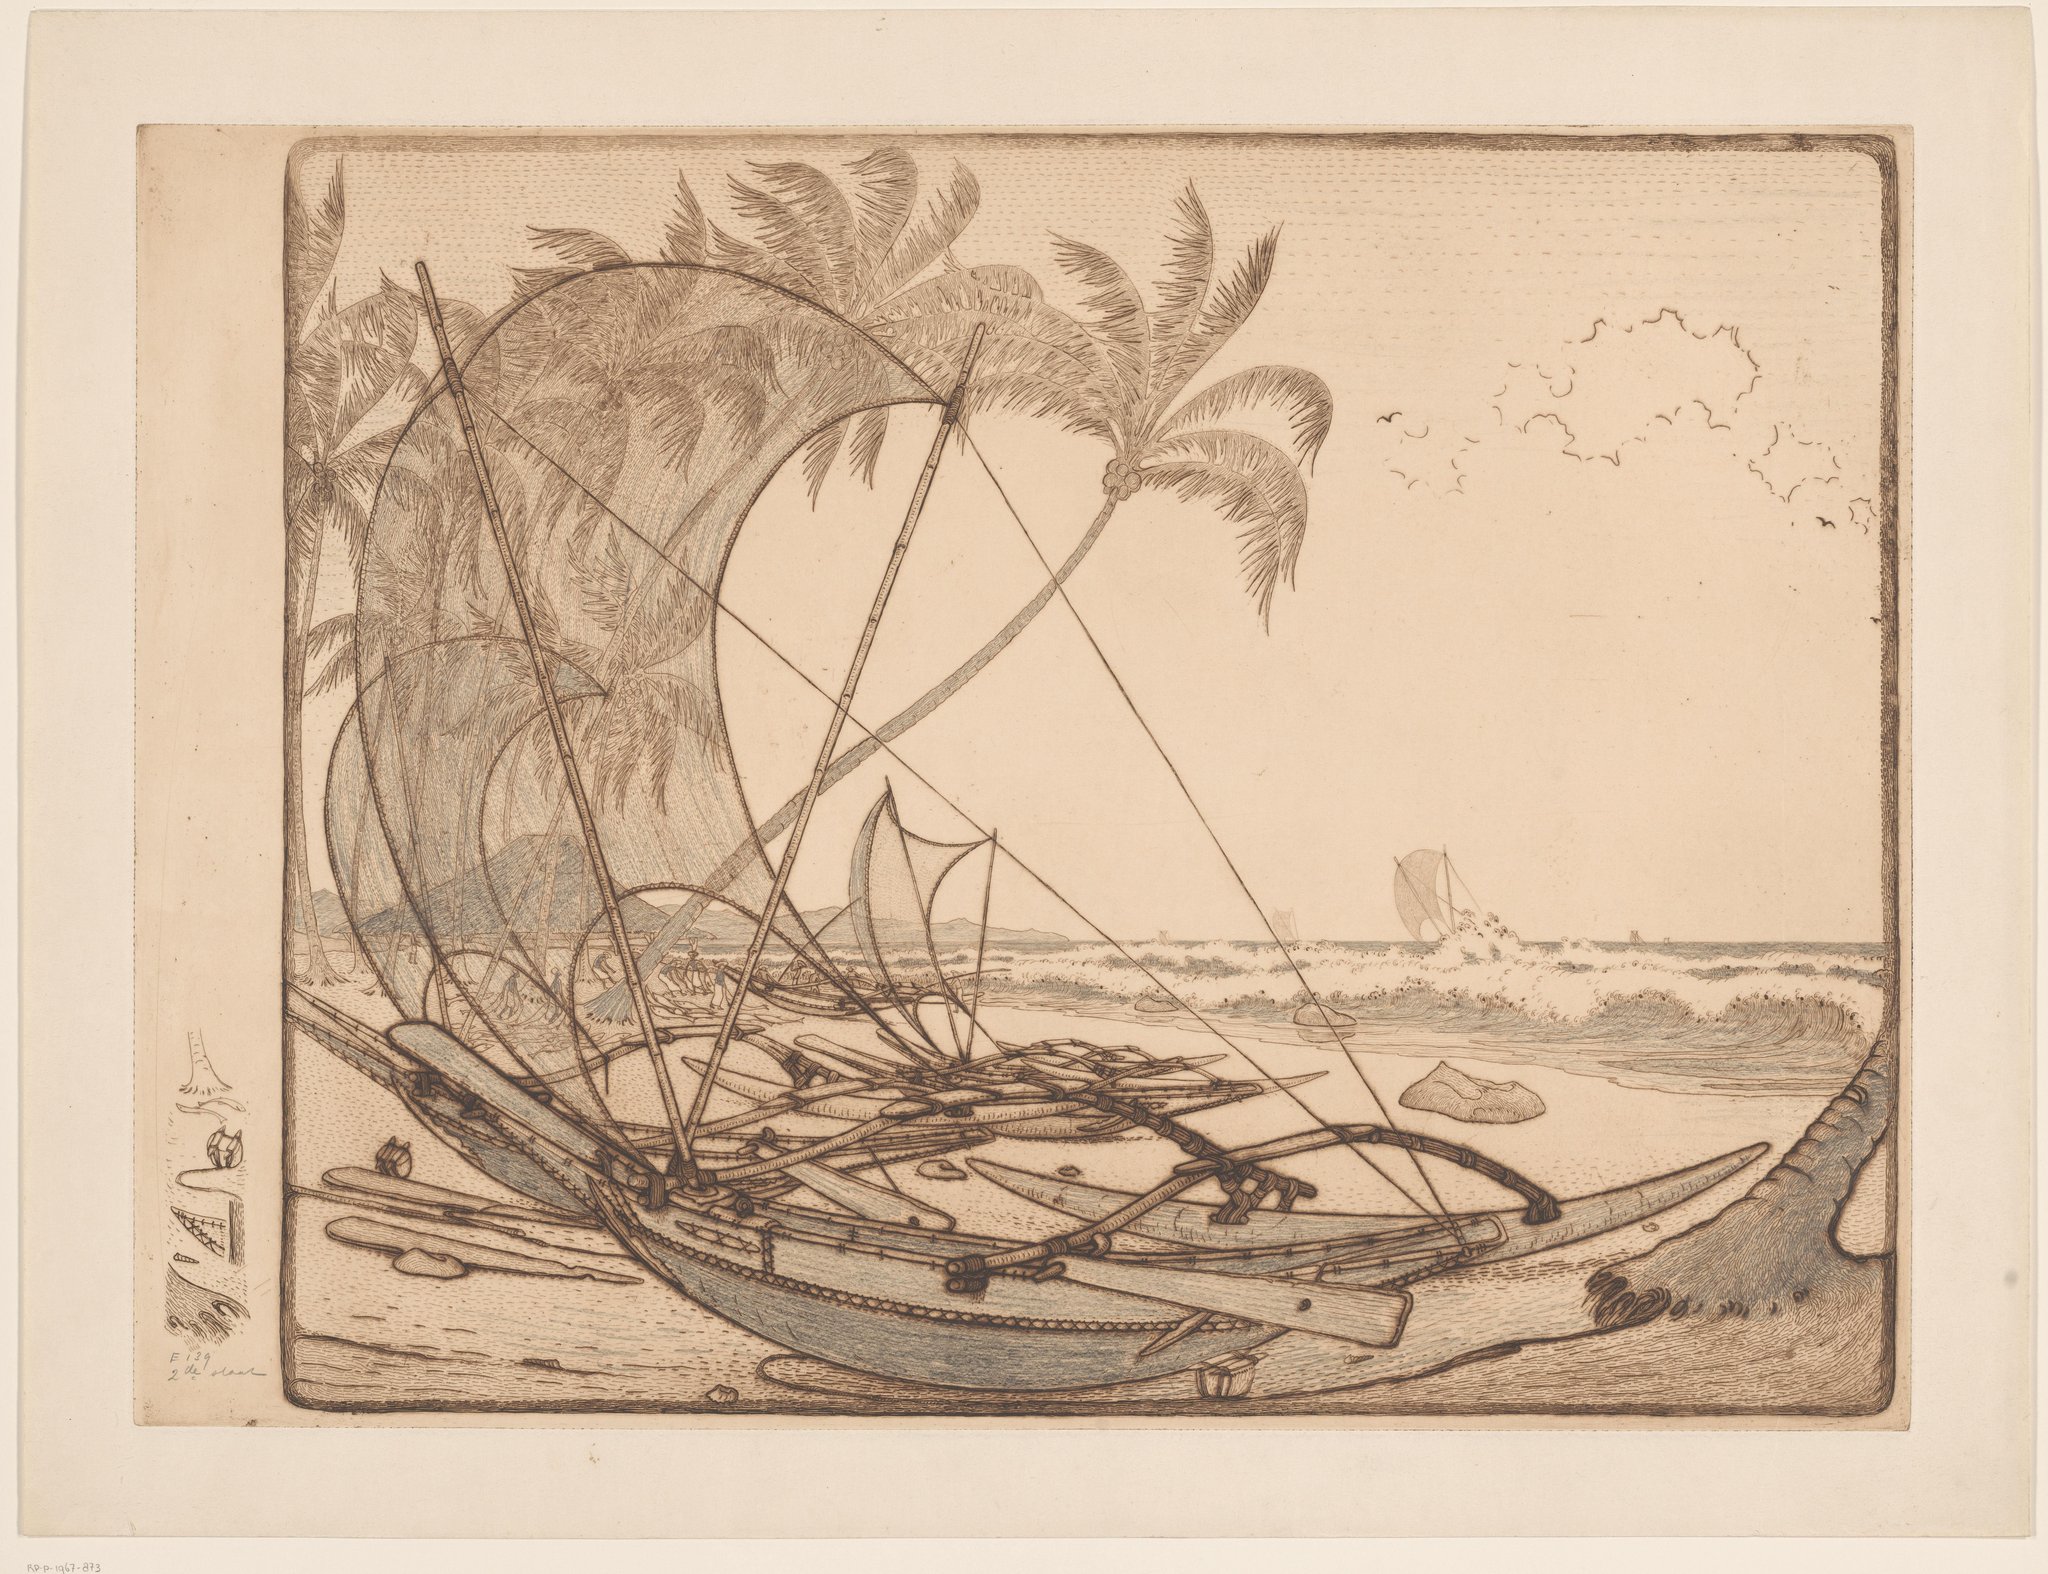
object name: print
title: Zeilen drogen in Colombo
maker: wijnand otto jan nieuwenkamp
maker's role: draughtsman, print maker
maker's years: 1874-1950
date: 1913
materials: paper, pencil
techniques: etching, retroussage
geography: edam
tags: sail, sailing-ship, sailing-boat, ships, boats on land, beached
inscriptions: collector's mark: Lugt 2228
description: Naar schets van 23 januari 1904, gemaakt tijdens oponthoud in Colombo tijdens Nieuwenkamps tweede reis naar Nederlands-Indië.